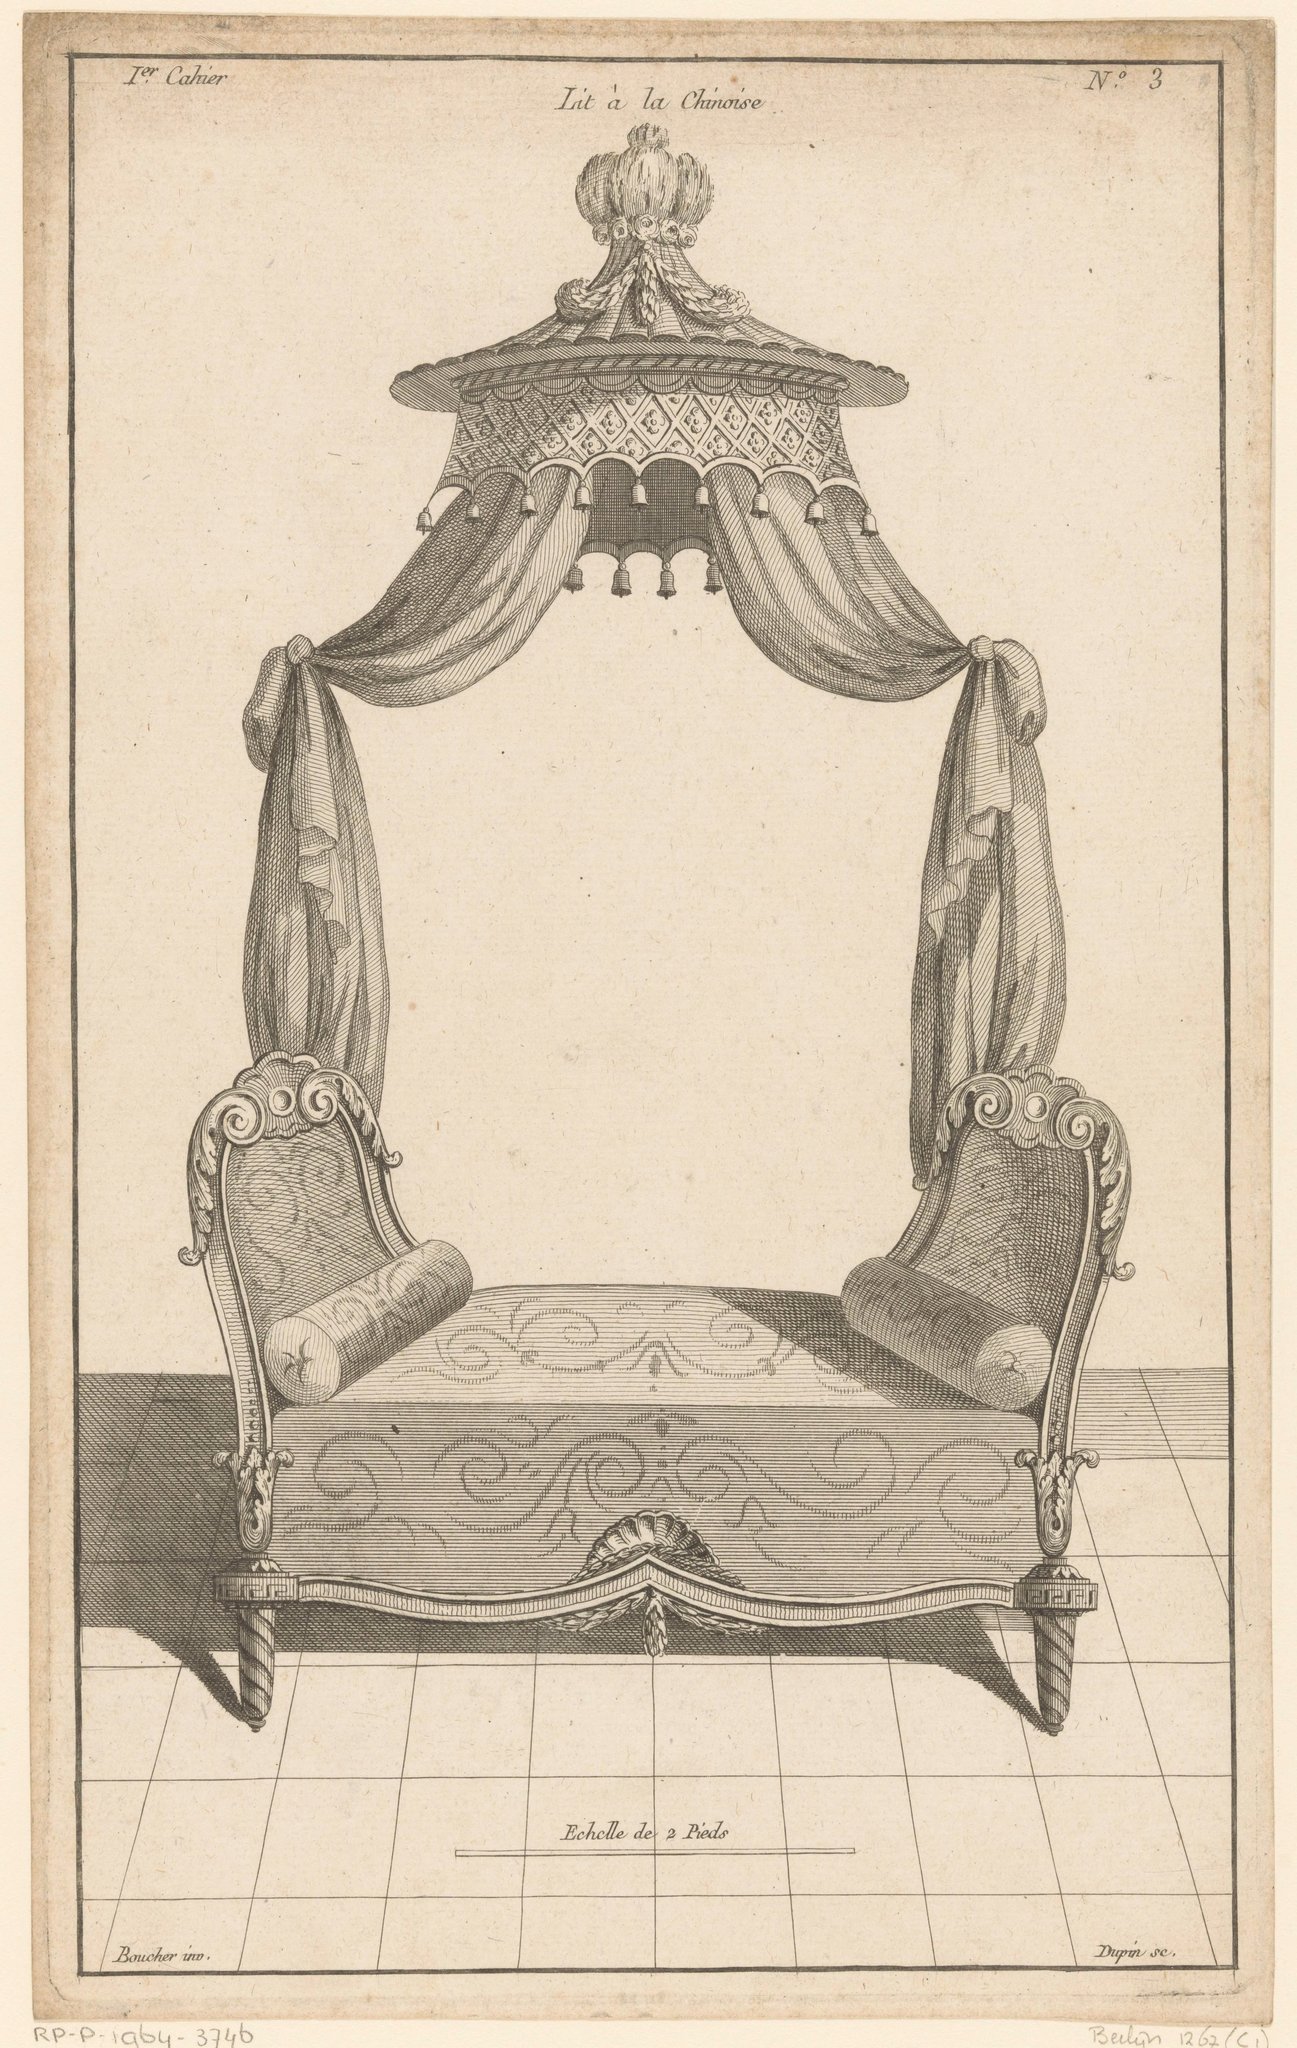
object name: print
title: Lit à la Chinoise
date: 1772-1779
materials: paper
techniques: engraving, etching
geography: paris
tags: bed with tester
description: Een geornamenteerd bed met rolkussens en een baldakijn gedecoreerd met bellen. Prentnummer 3.